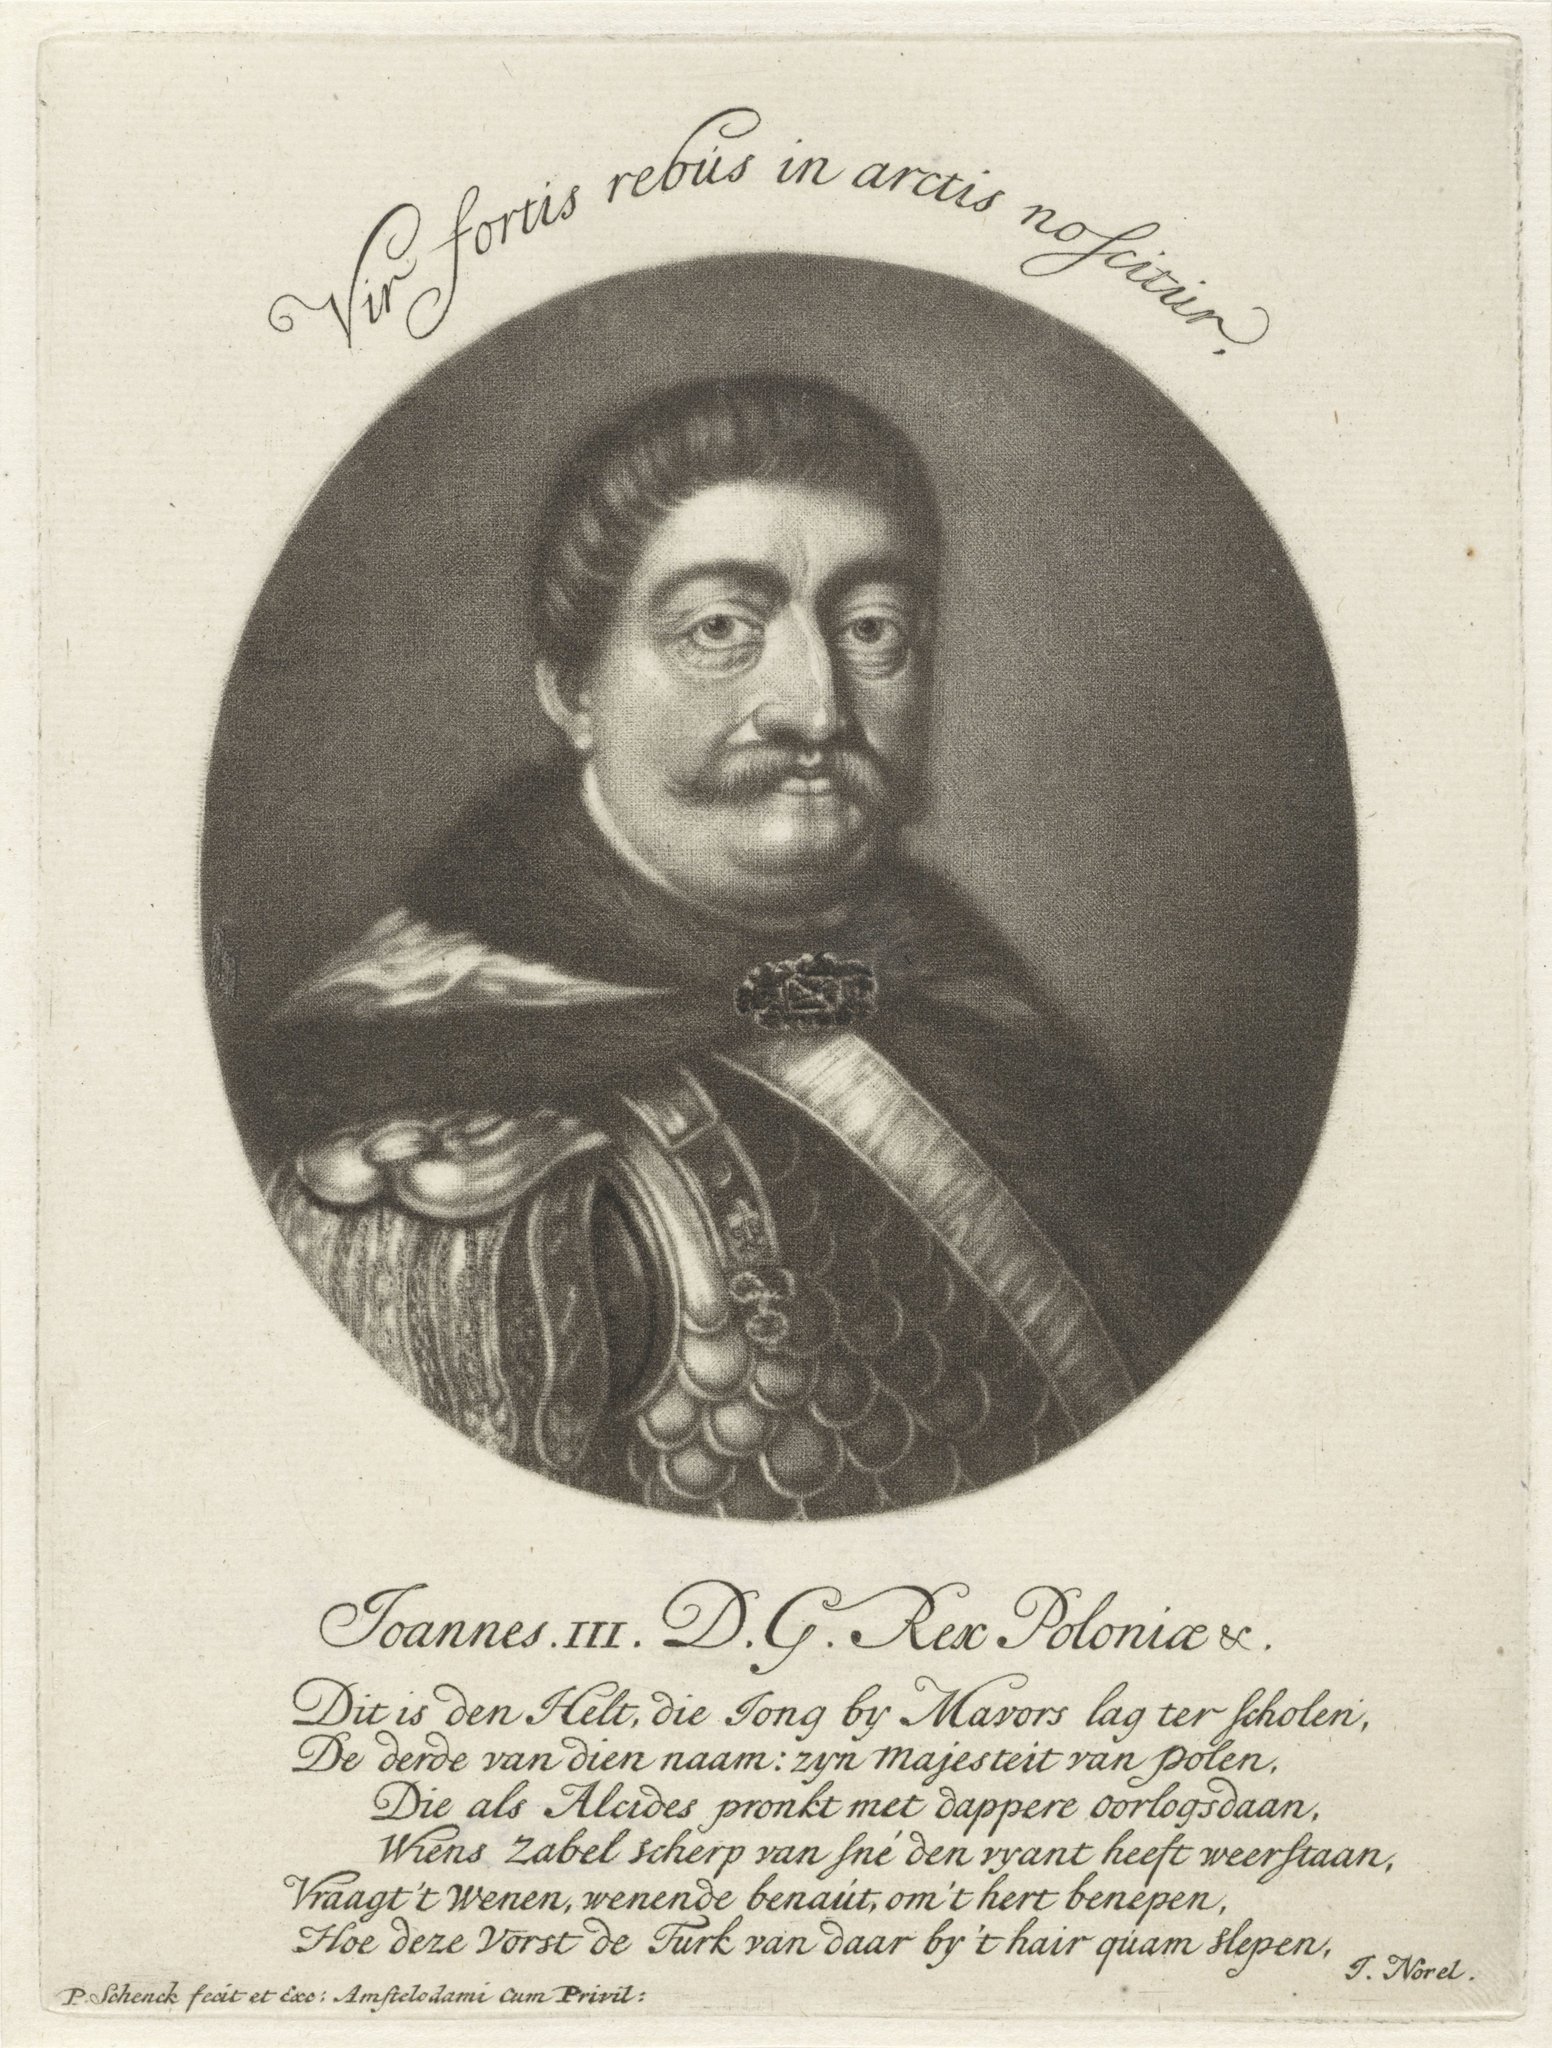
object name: print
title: Portret van Jan III Sobieski, koning van Polen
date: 1670-1713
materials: paper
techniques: engraving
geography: amsterdam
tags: jan iii sobieski (koning van polen)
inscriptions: collector's mark: Lugt 2228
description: Jan III Sobieski, koning van Polen. In de marge een gedicht over zijn strijdkunsten en dapperheid.